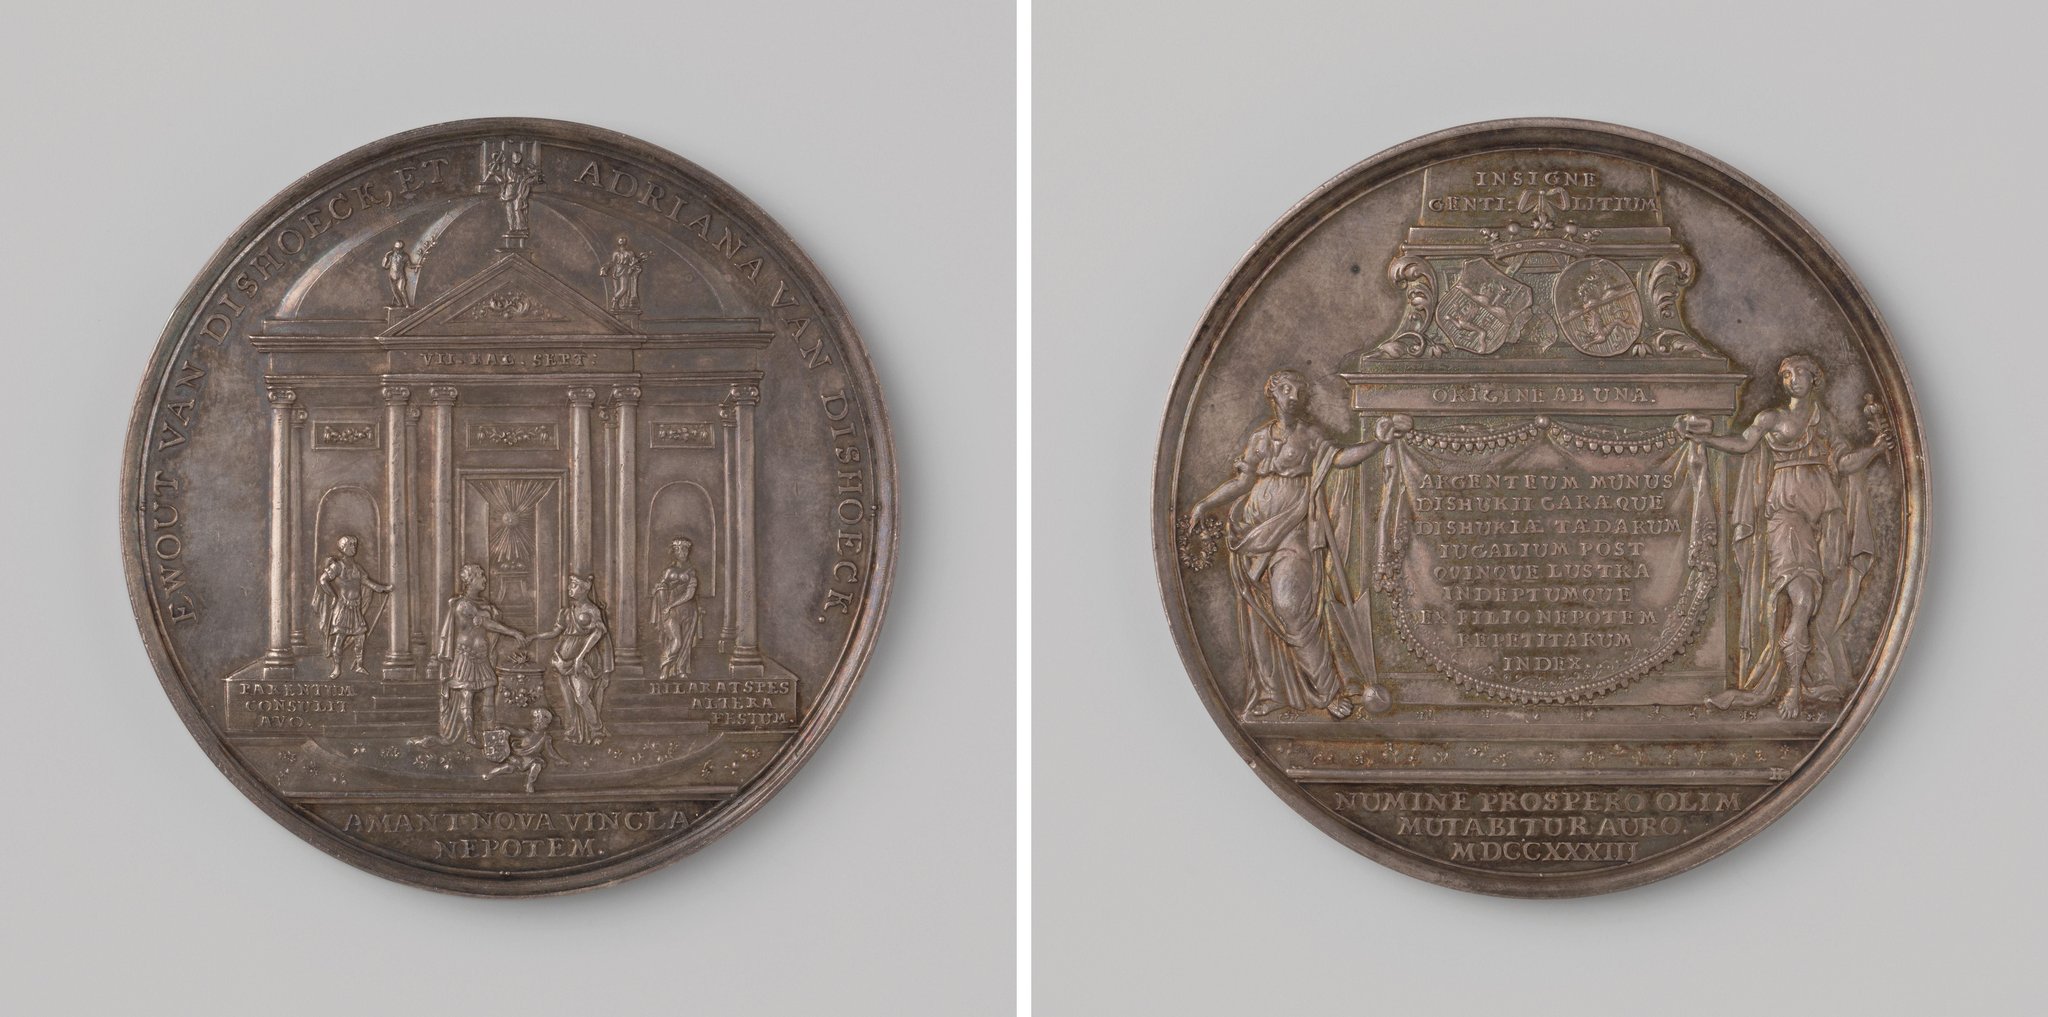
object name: marriage medal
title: Vijfentwintigjarig huwelijk van Ewout van Dishoeck, heer van Domburg, ordinaris raad van Indie, admiraal, kiesheer, schepen en raad van Middelburg en Adriana van Dishoeck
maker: martinus holtzhey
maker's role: medailleur, muntmaker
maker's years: 1697-1764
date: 1733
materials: silver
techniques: striking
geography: amsterdam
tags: middelburg